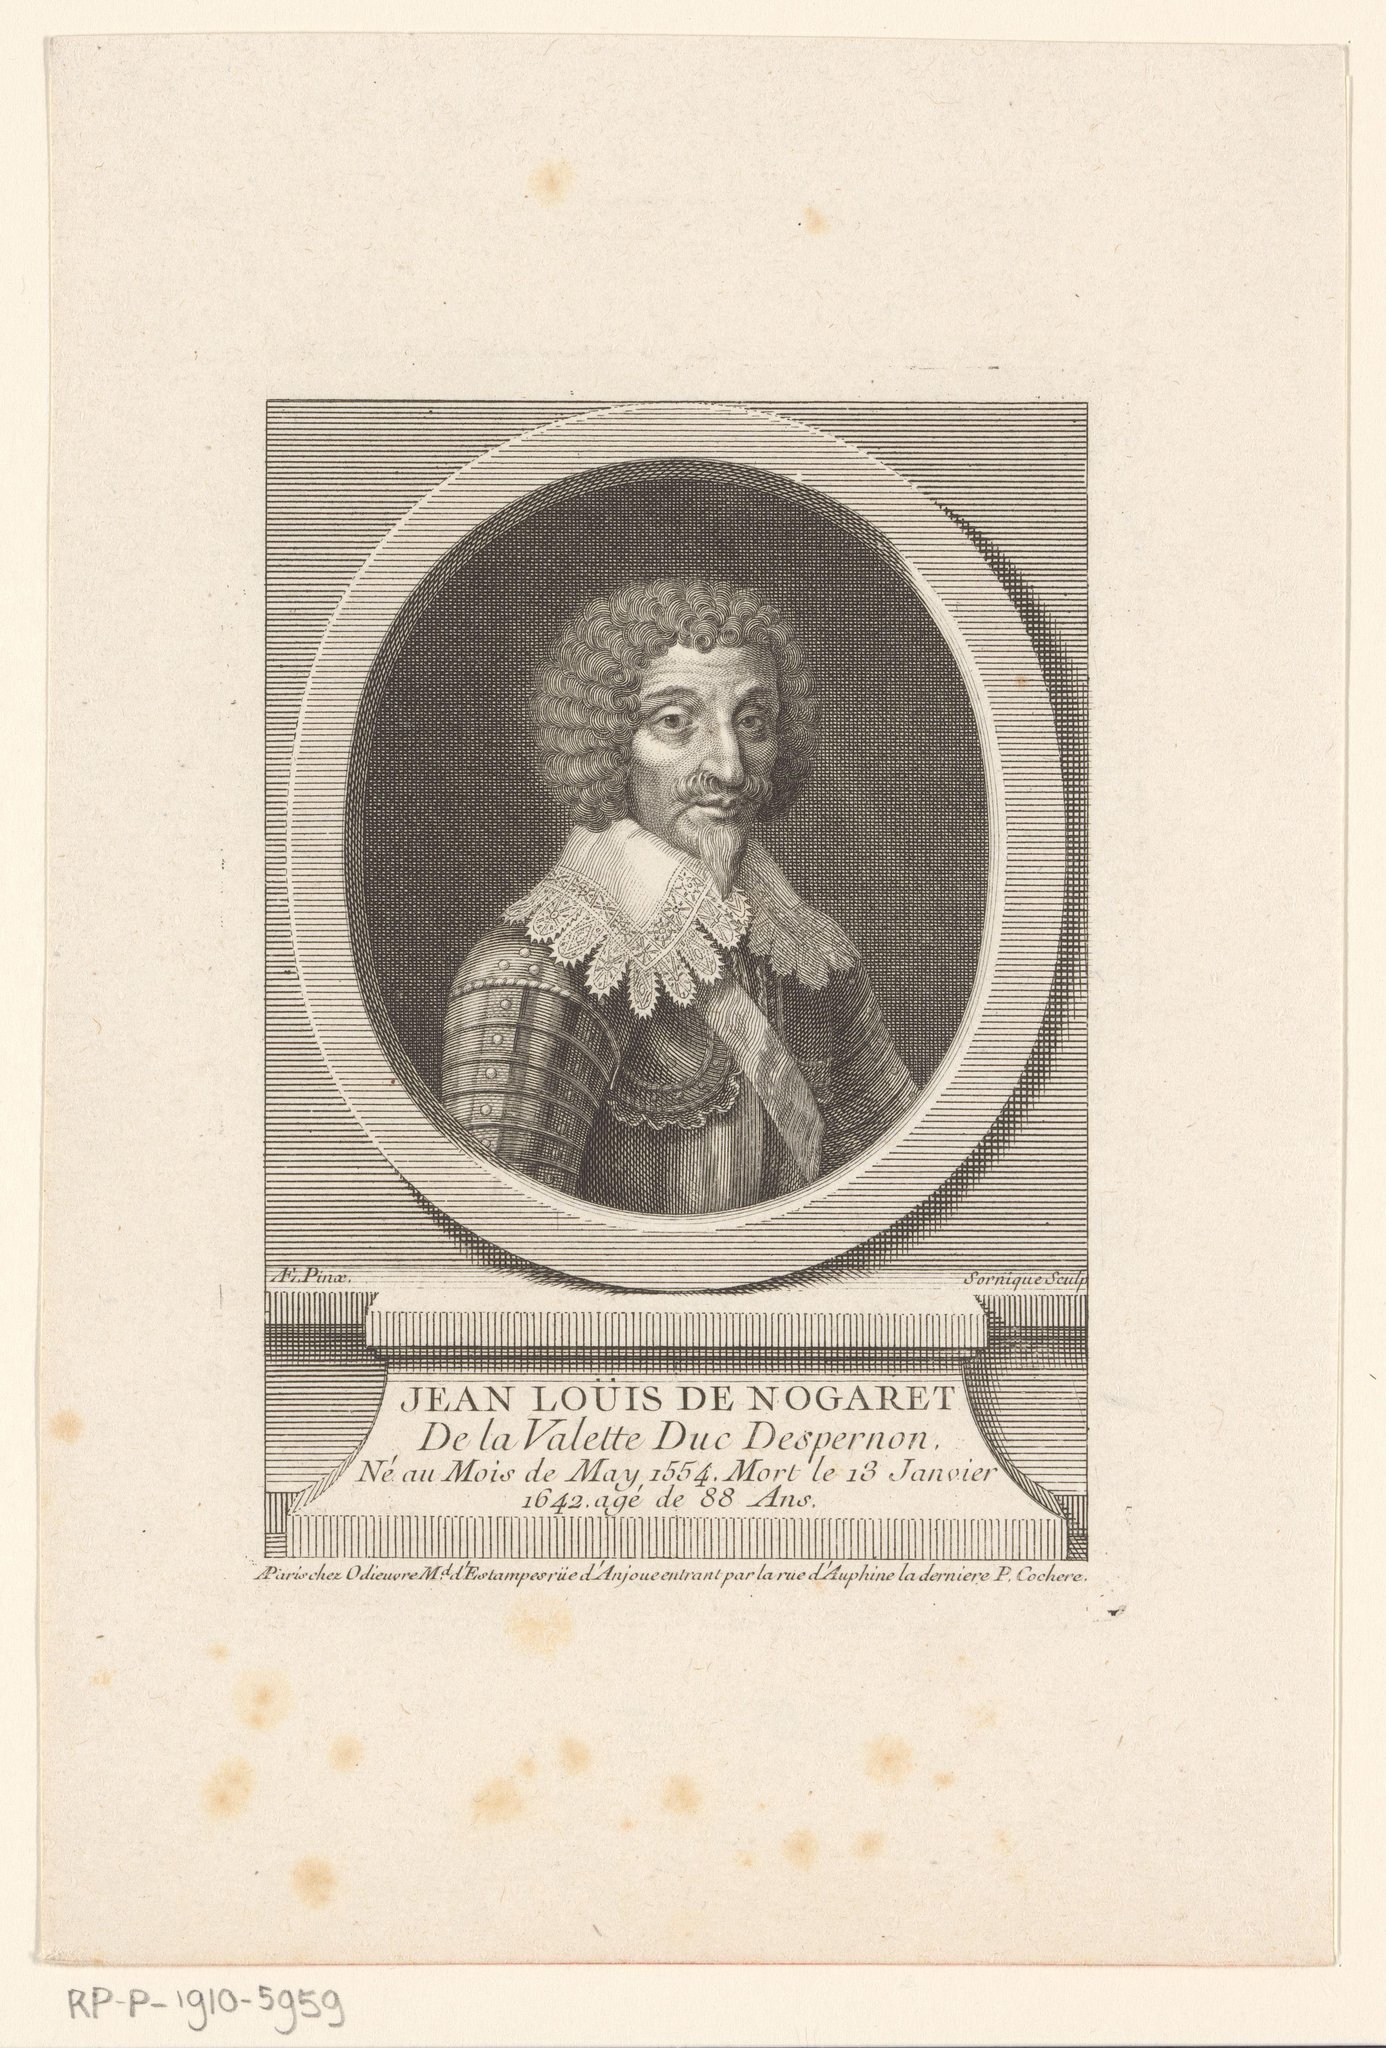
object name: print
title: Portret van Jean-Louis de Nogaret de la Valette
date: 1755-1765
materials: paper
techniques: engraving, etching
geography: paris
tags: politician, ranks in the army, historical persons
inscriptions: collector's mark: Lugt 2228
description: Prent uit: Dreux du Radier, Jean-François. L'Europe illustré, contenant l'histoire abregée des souverains, des princes, des prélats, des ministres, (...) en Europe: dans le XVe. siècle compris, jusqu'à présent. Parijs: Michel Odieuvre en André-François Le Breton, 1755-1765.